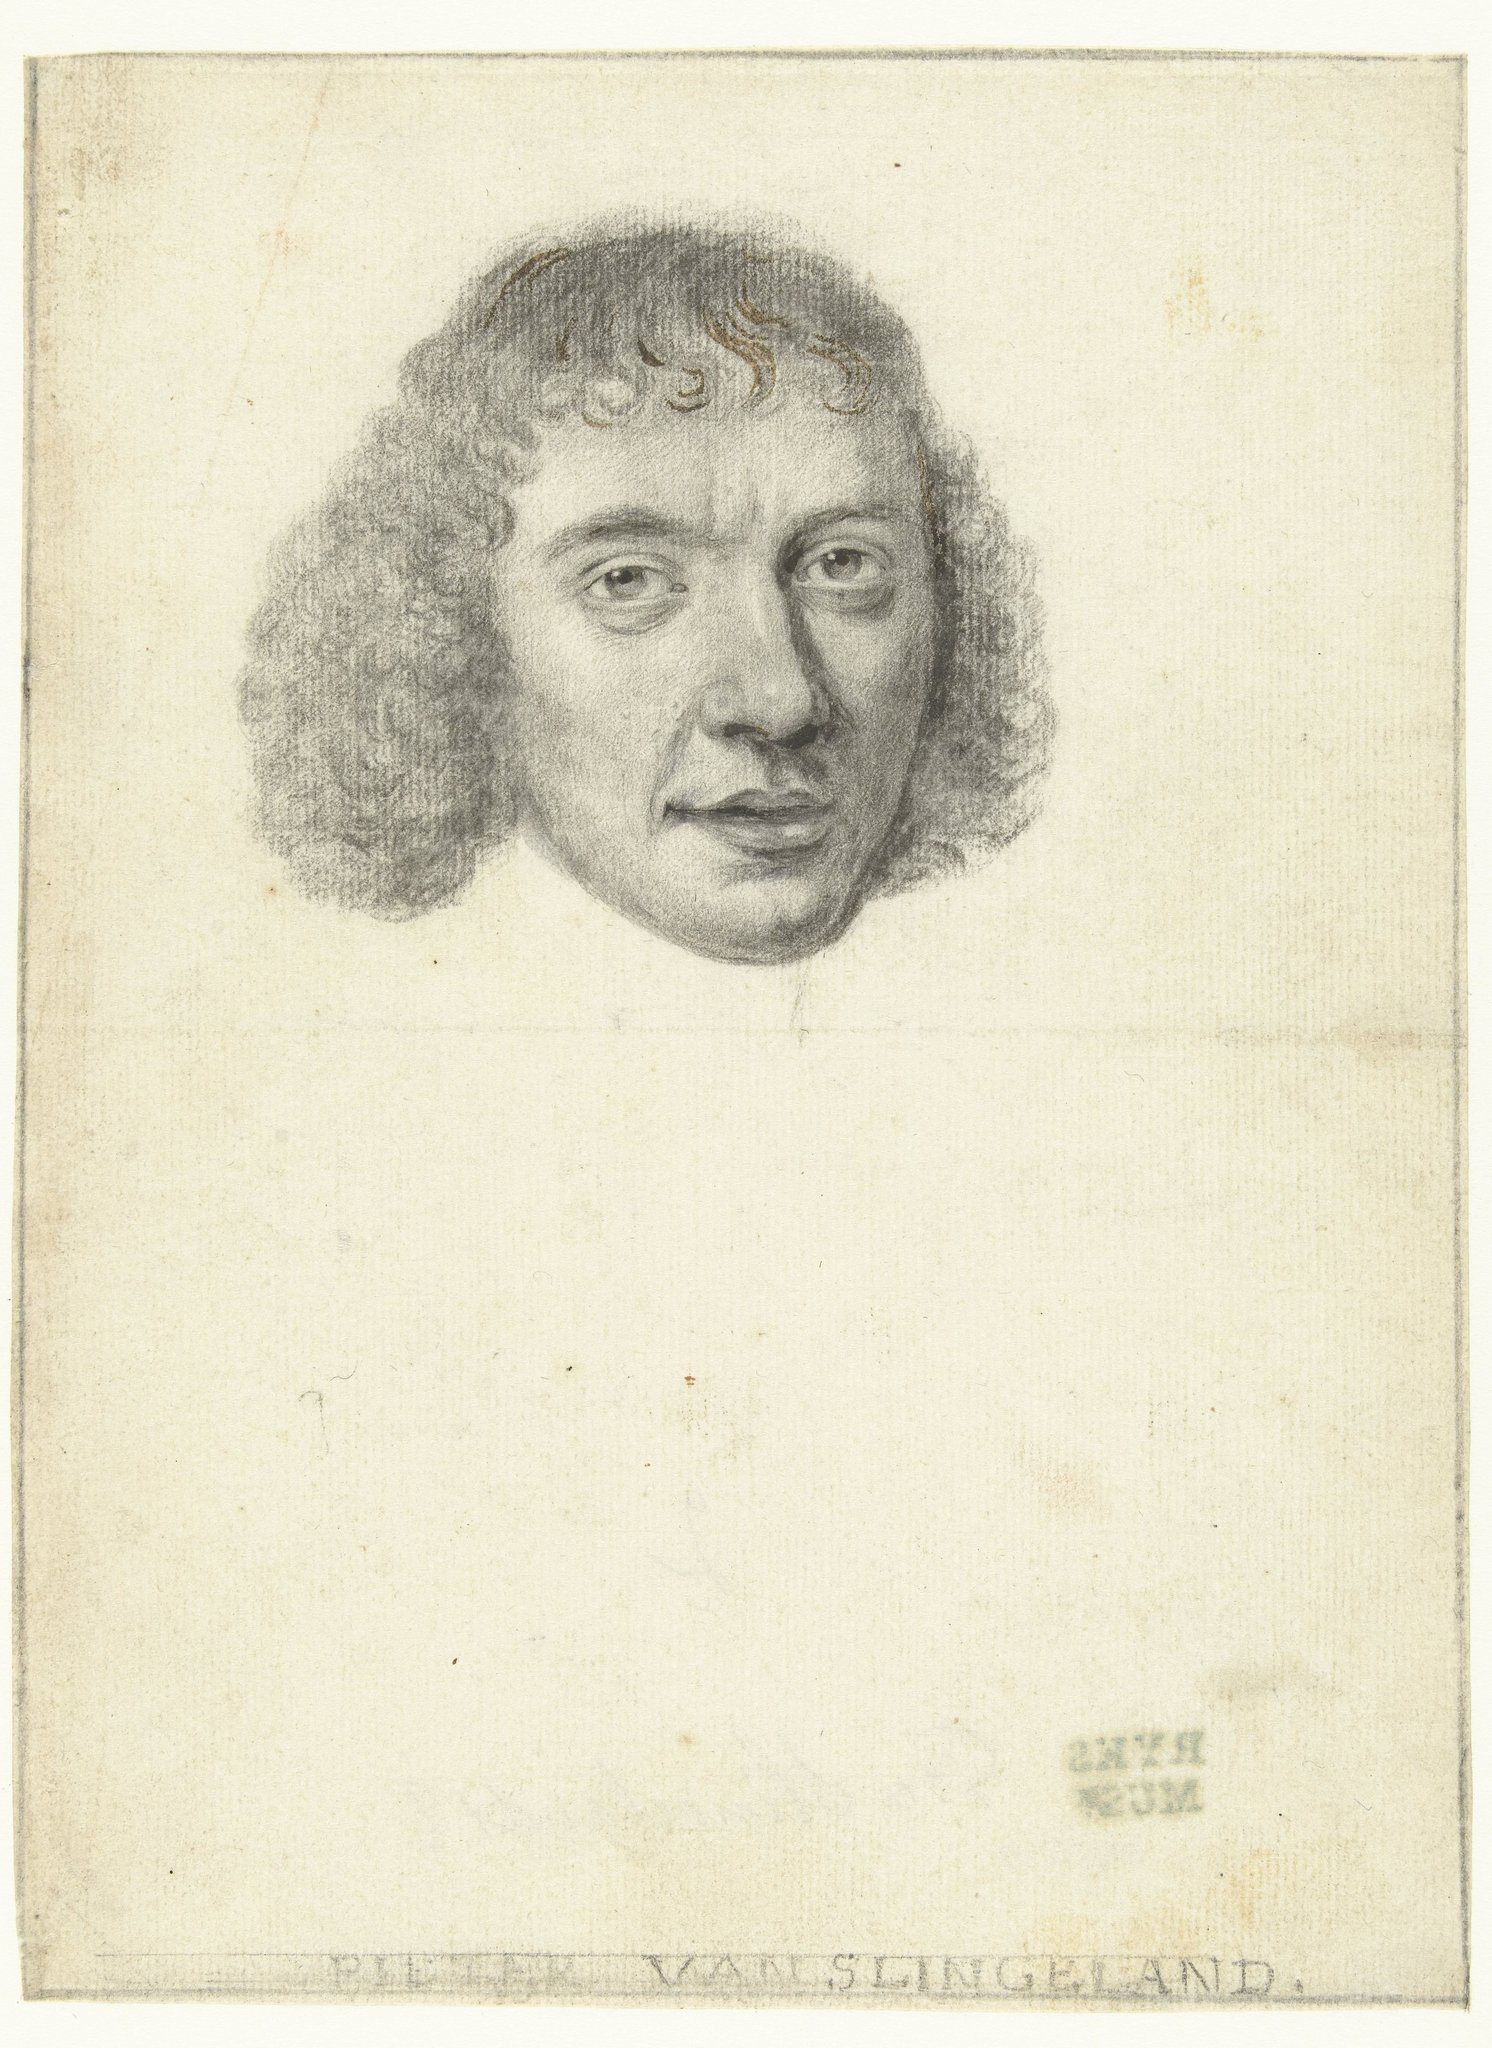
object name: drawing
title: Portret van een onbekende man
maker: pieter cornelisz. van slingelandt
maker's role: draughtsman, painter, print maker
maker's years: 1640-1691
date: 1650-1691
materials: chalk, ink, paper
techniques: pen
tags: head (human), anonymous historical person portrayed alone